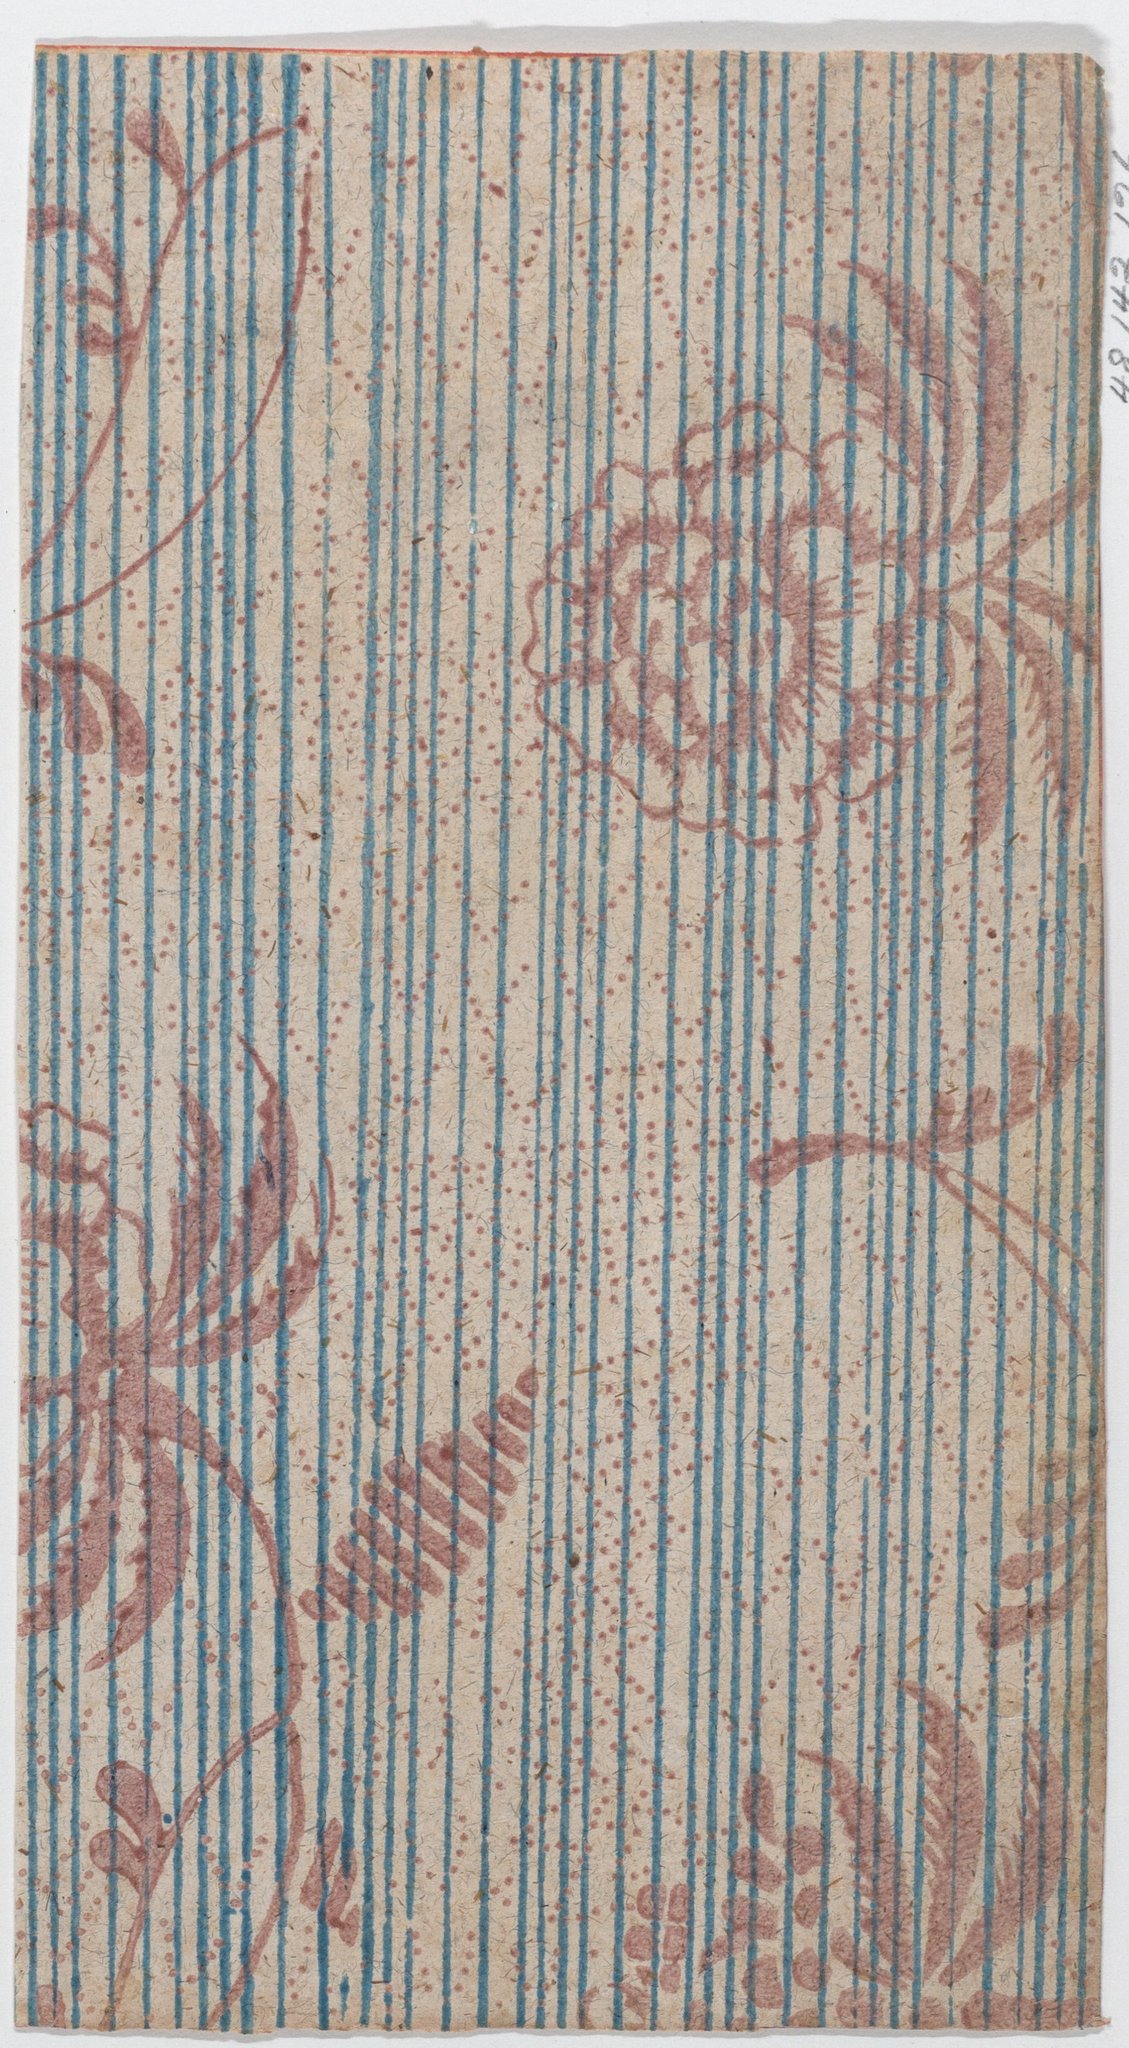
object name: print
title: Sheet with two borders with an overall dot pattern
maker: Anonymous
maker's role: artist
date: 1767-1866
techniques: relief print